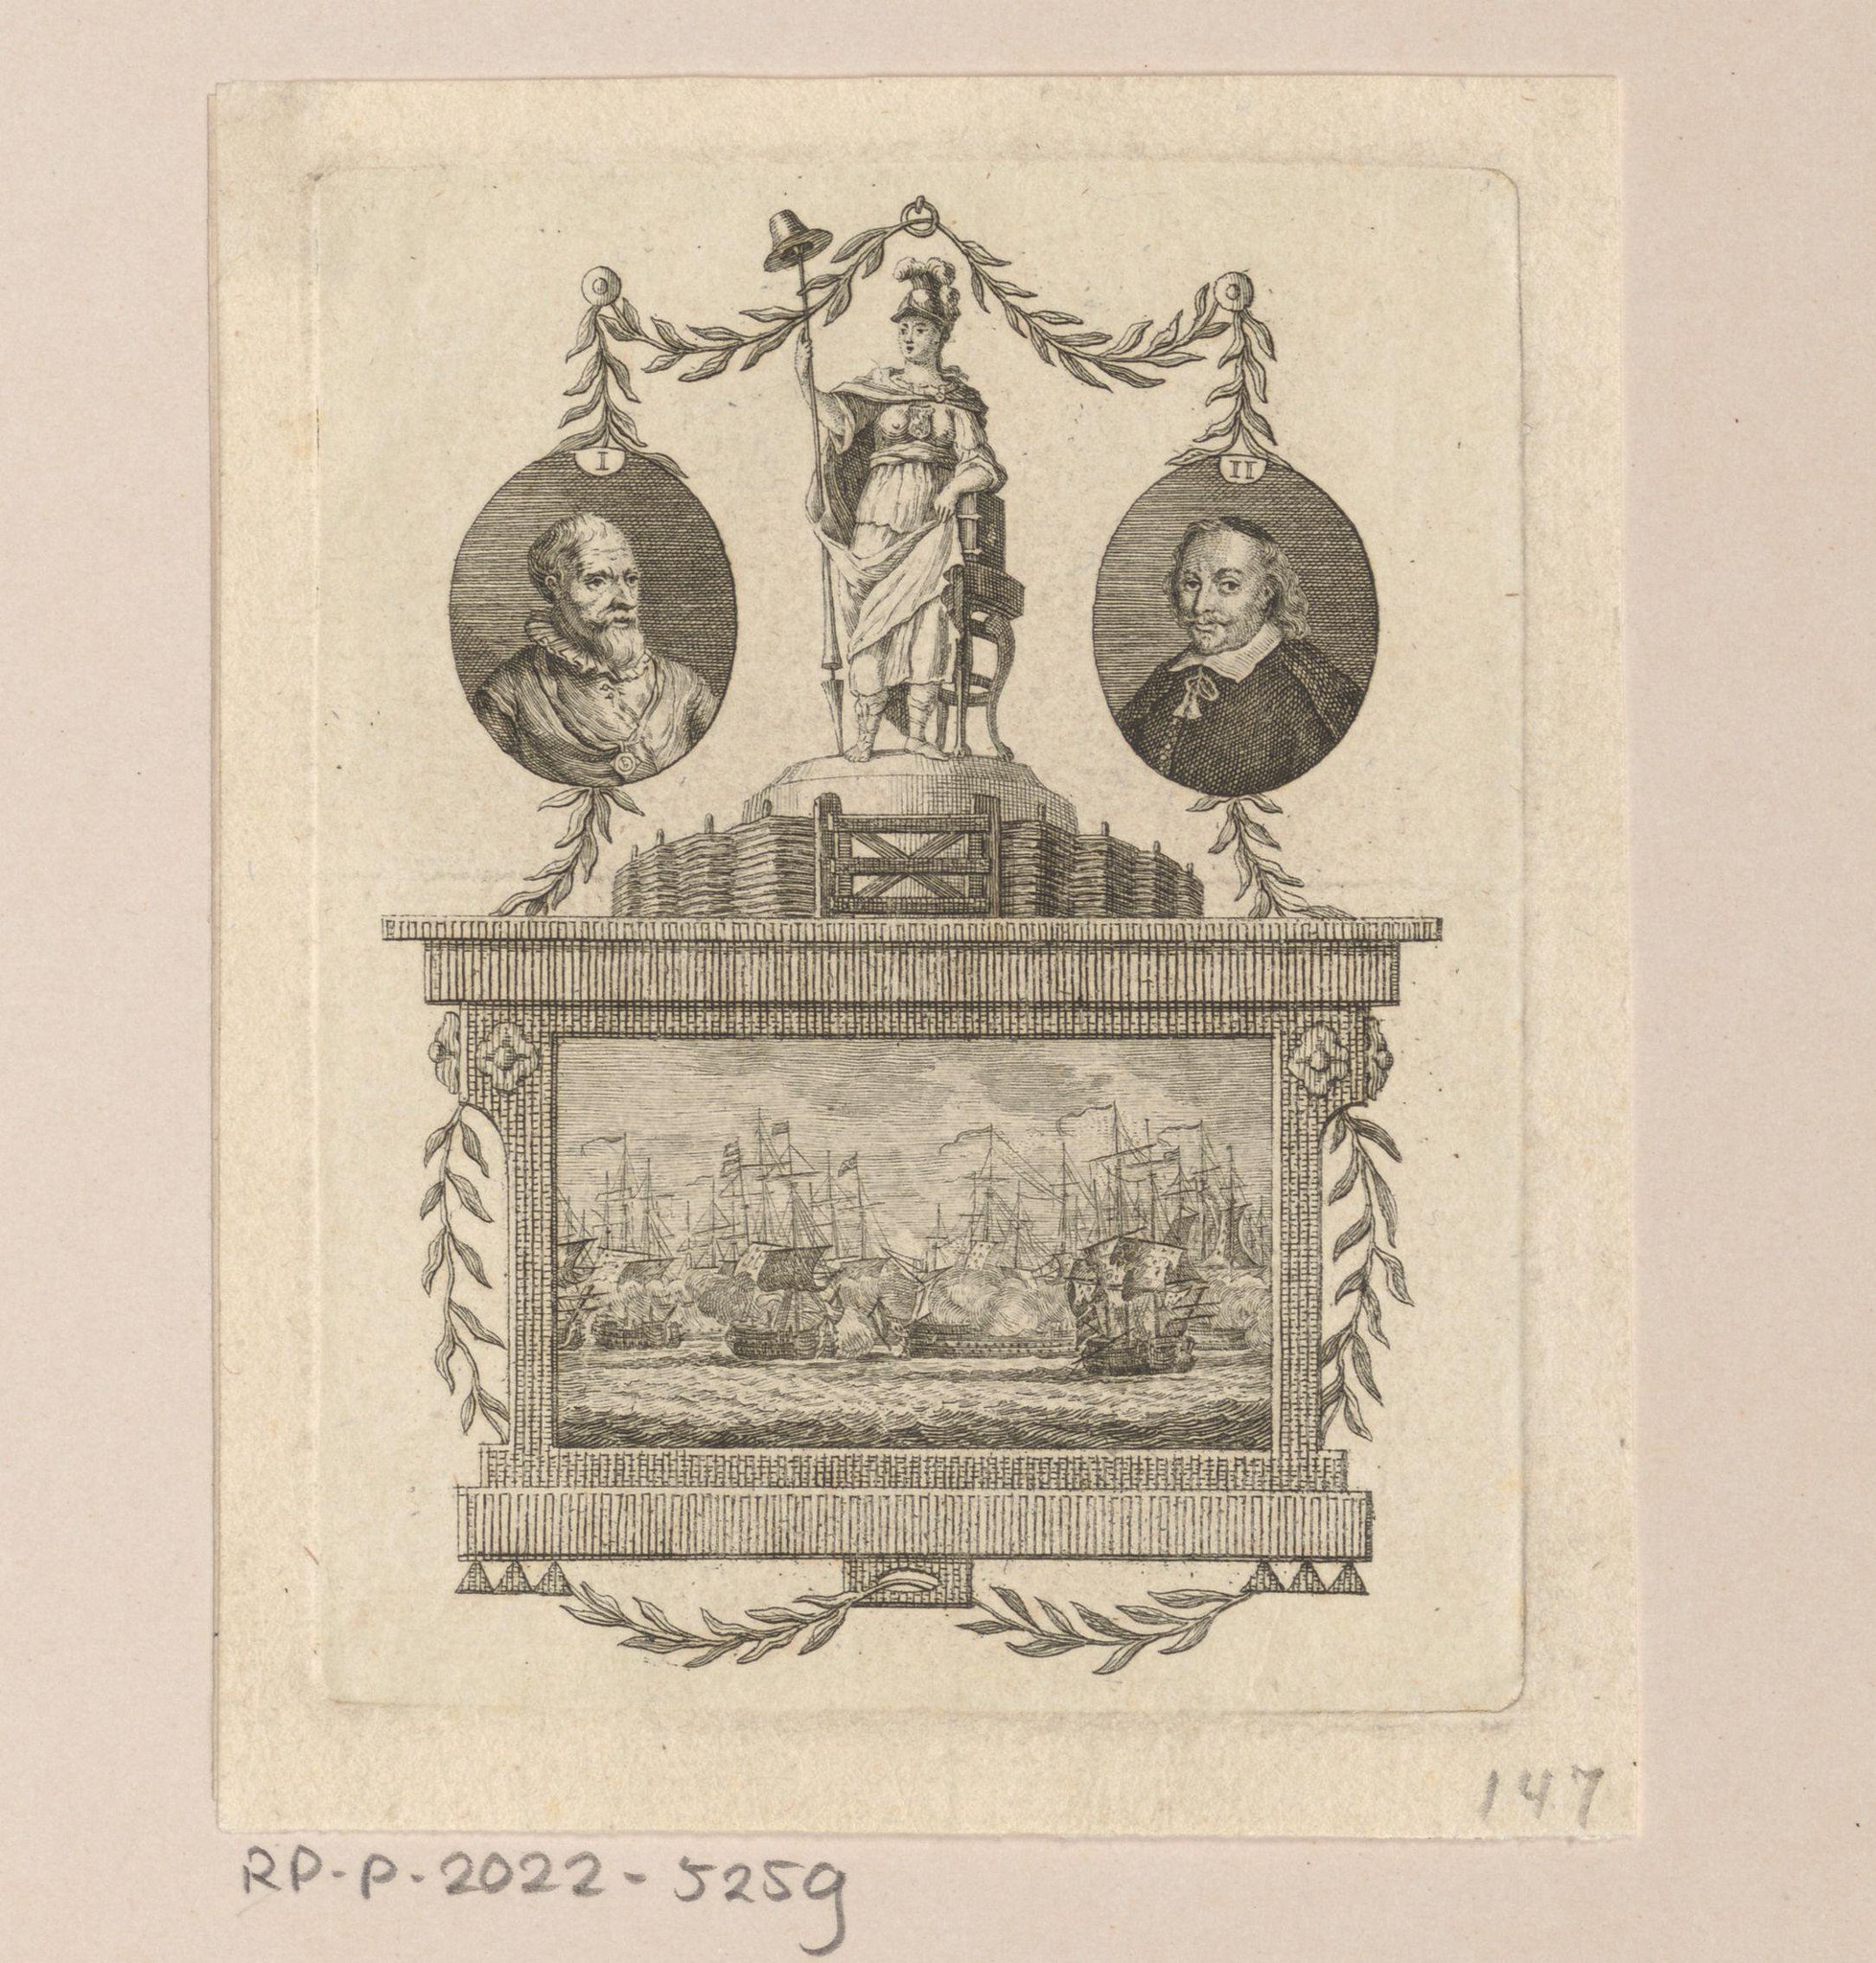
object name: print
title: Portretten van Pieter Adriaensz. van der Werff en een onbekende man in medaillons met een personificatie van de Nederlandse Republiek boven een zeeslag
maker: Anonymous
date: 1700-1799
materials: paper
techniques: engraving, etching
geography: northern netherlands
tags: battle (+ naval force), historical persons, personifications of countries, nations, states, districts, etc. (+ nation; national)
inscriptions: number: ‘147’